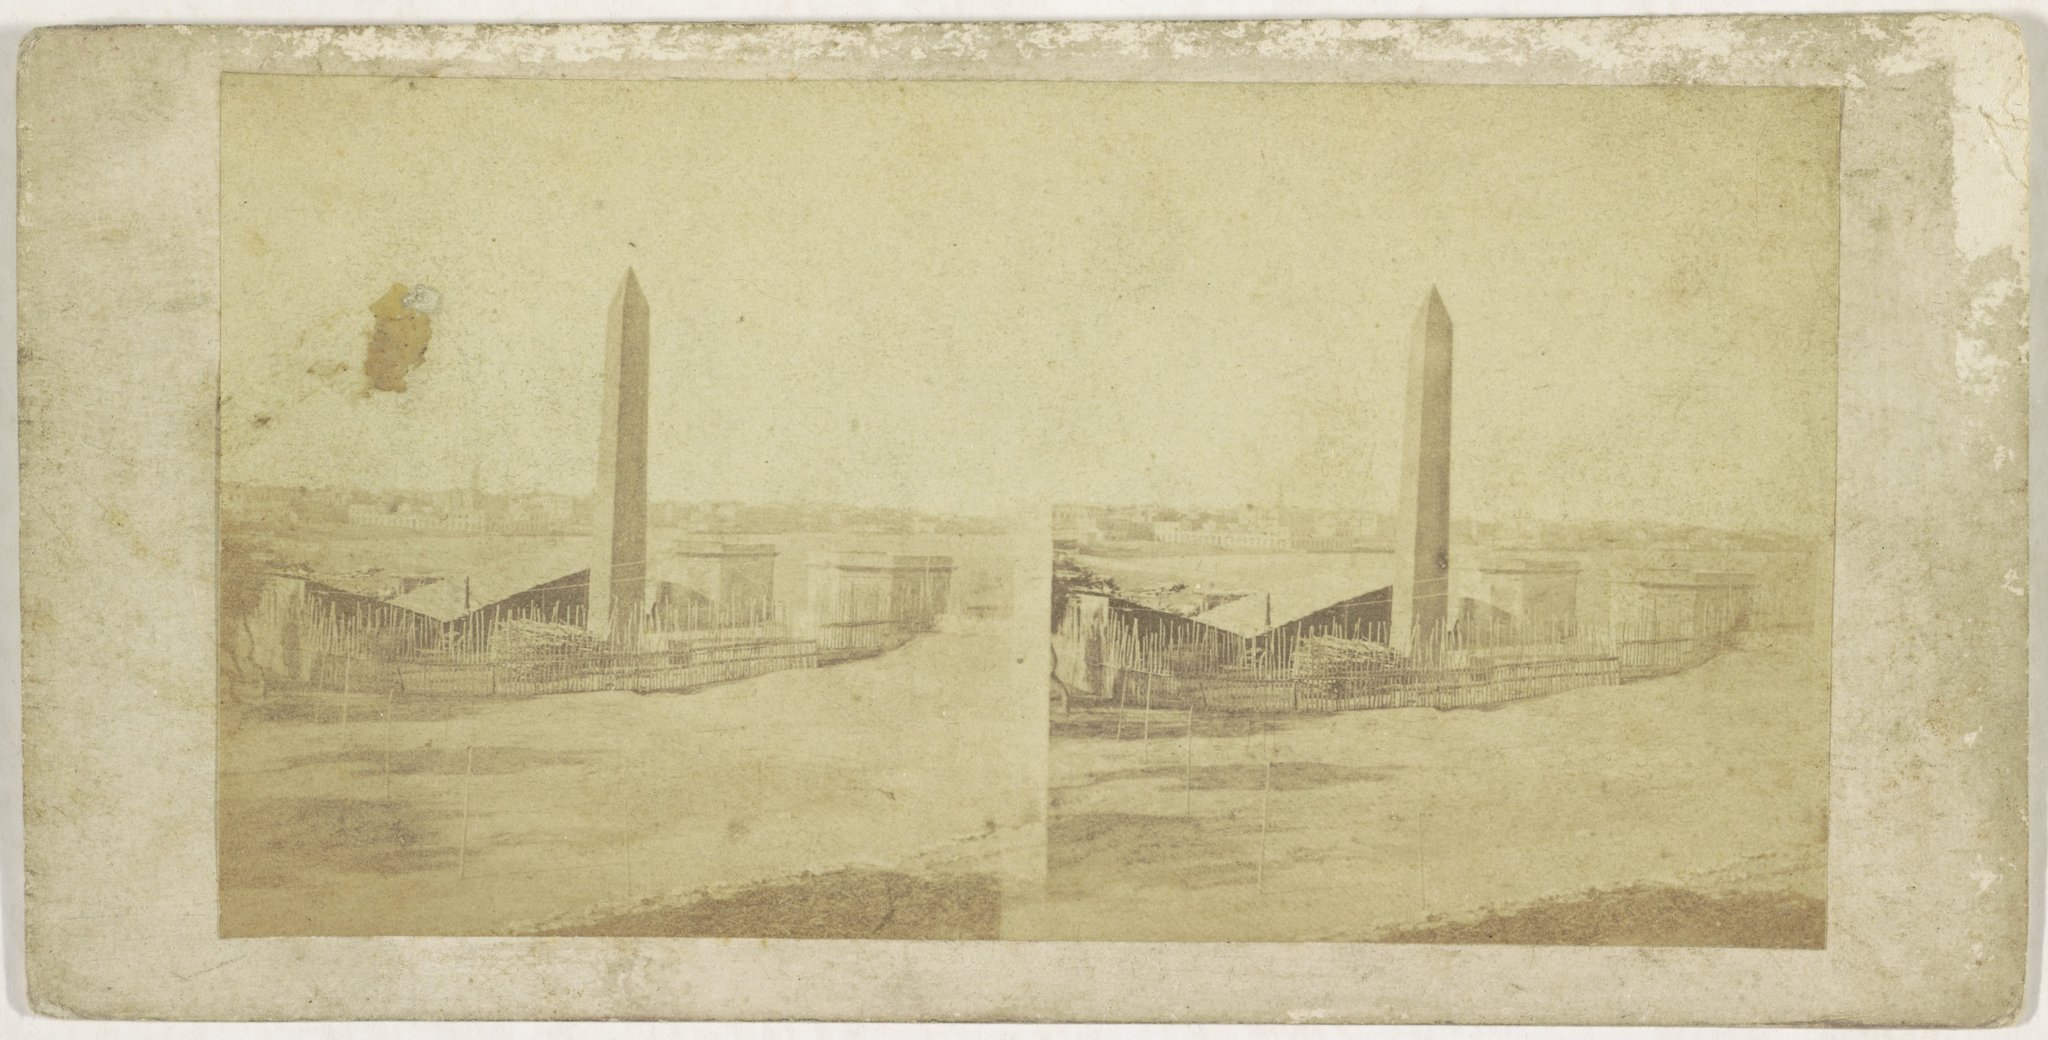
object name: stereograph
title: Gedenknaald van Cleopatra te Alexandrië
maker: Anonymous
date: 1852-1858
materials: cardboard, paper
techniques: albumen print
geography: alexandria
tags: obelisk, needle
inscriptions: stamp: ‘T. C. A. MANDERS/ Amsterdam’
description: De afgebeelde obelisk werd in 1879 door Egypte geschonken aan de VS. De huidige standplaats is in Central Park, New York.